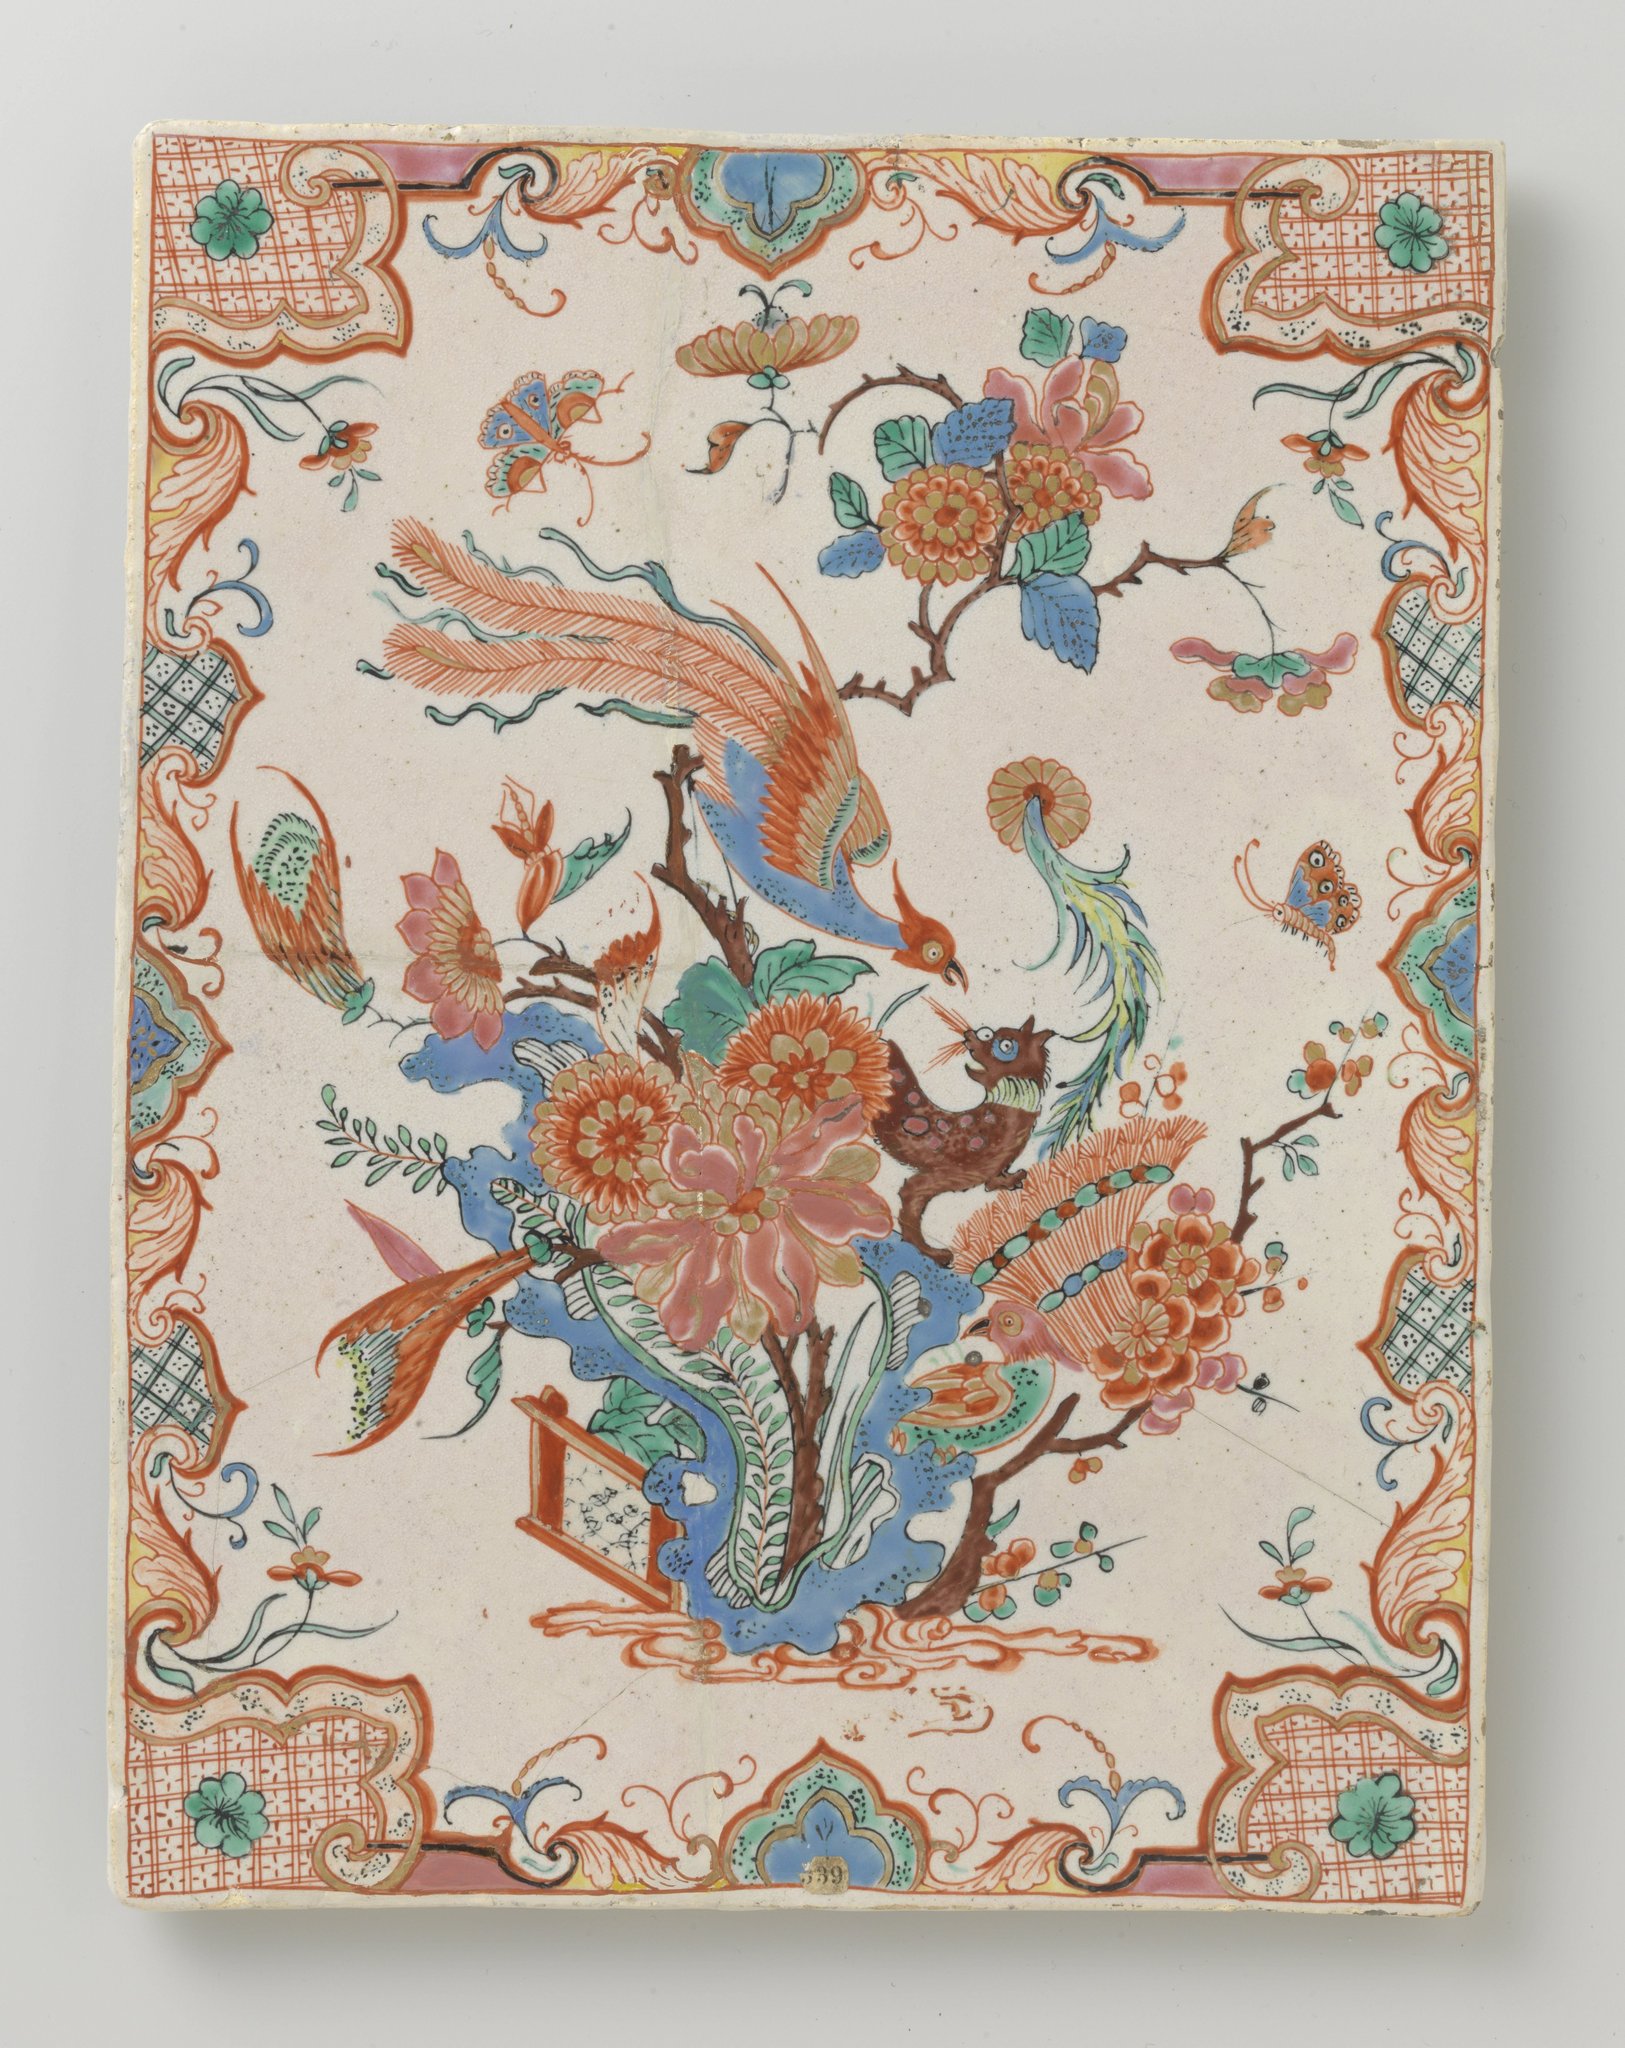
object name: plate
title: Veelkleurig beschilderde plaque van faïence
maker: Anonymous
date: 1720-1750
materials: faience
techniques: kiln, painted, polychromy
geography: delft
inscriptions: collector's mark: ‘collection JF Loudon’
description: Plaque veelkleurig beschilderd met een vogel, een onbekend dier, insecten en bloemtakken omlijst door lambrequins gevuld met servetwerk.